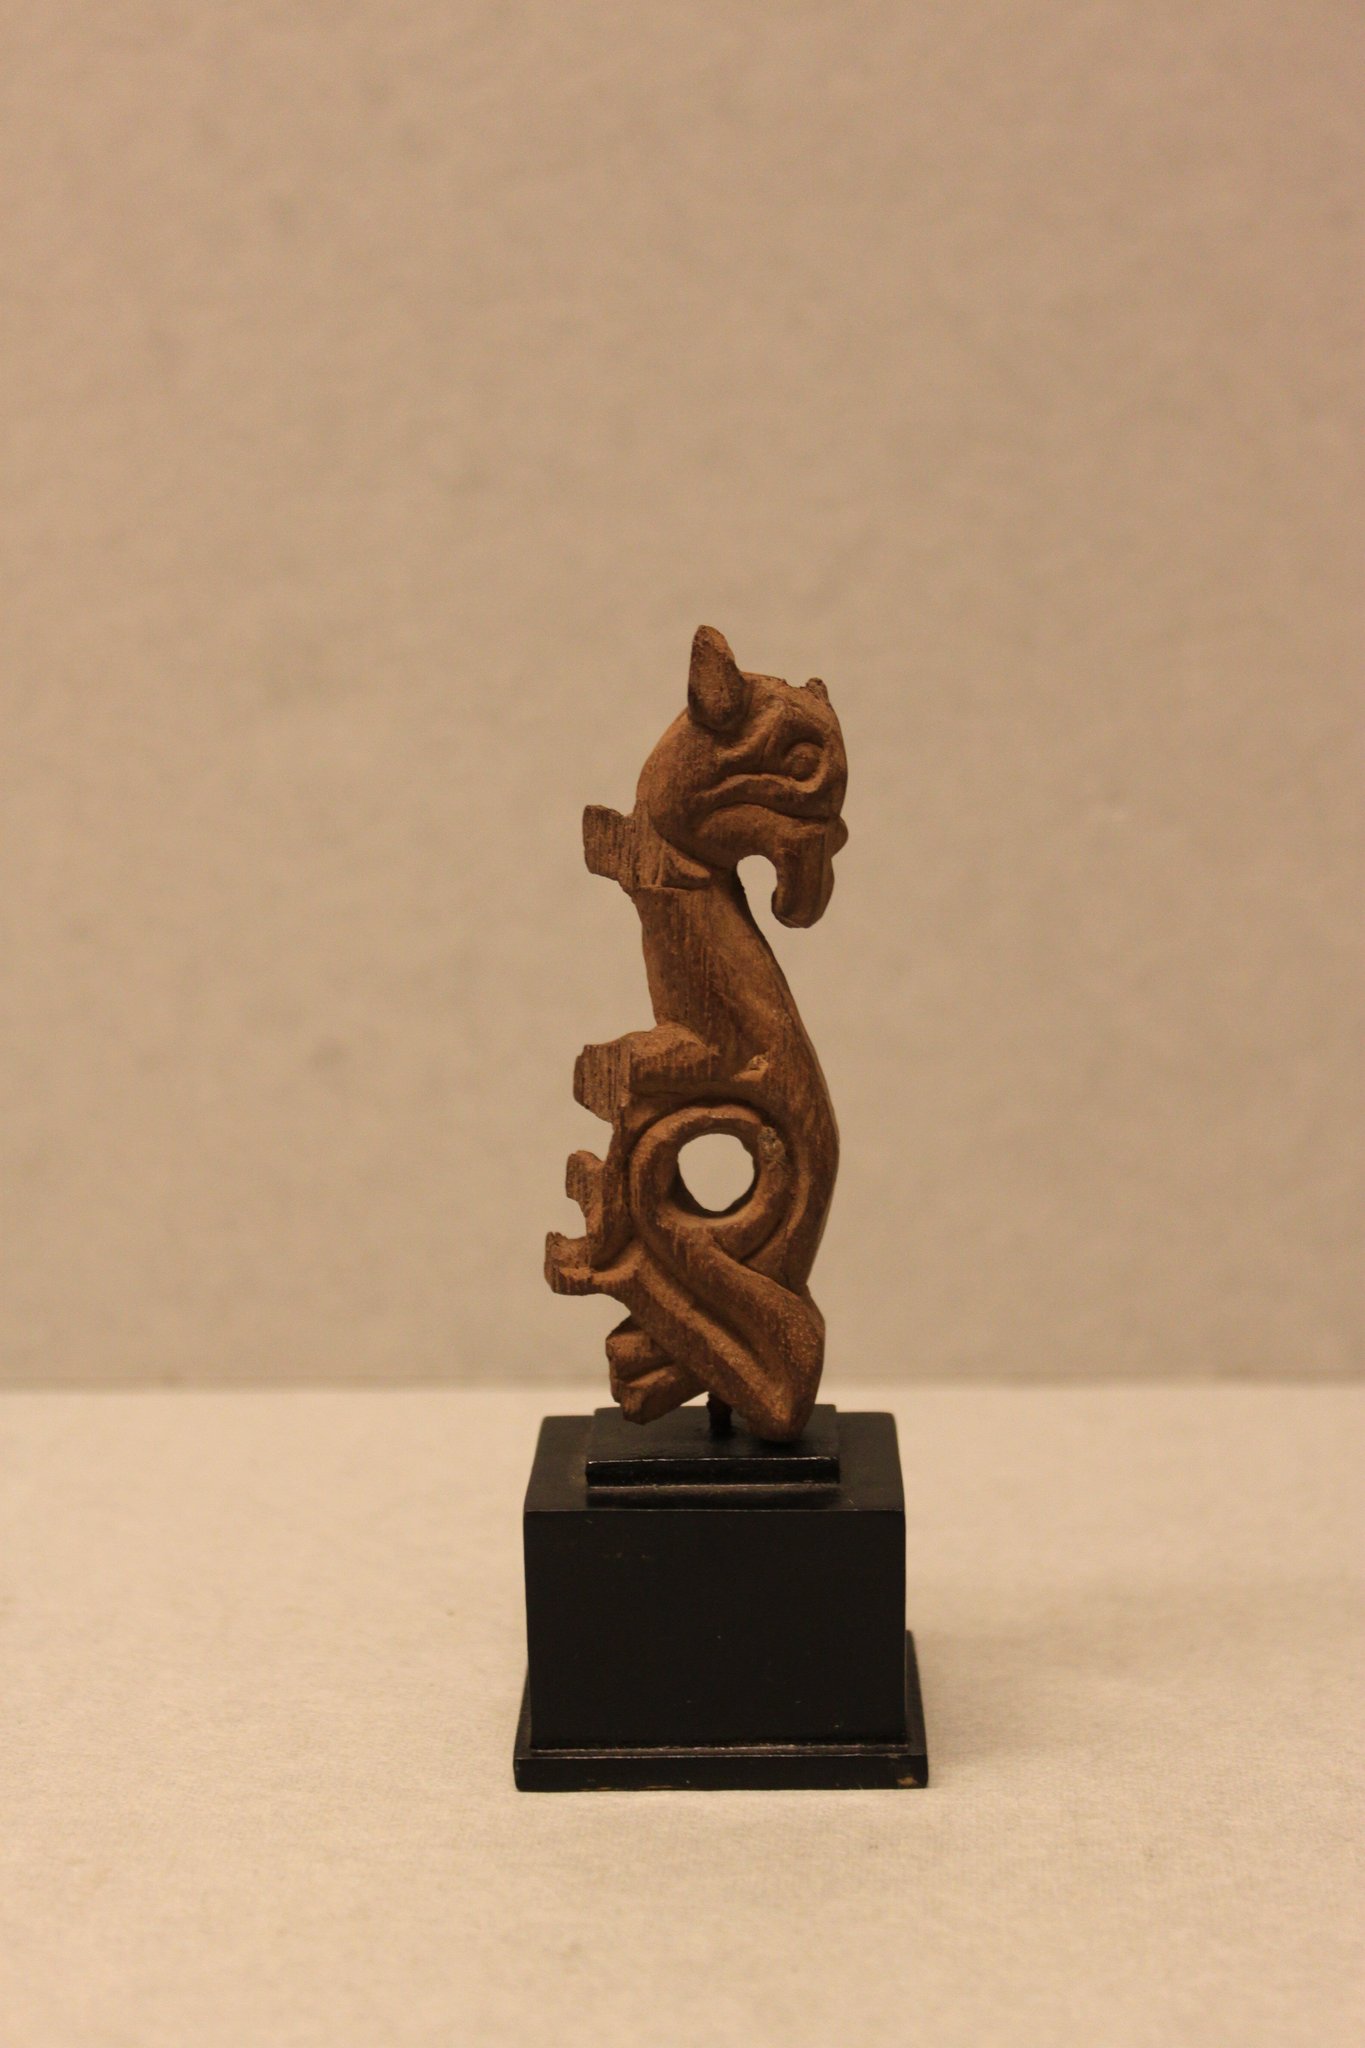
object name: panel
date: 901-1400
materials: wood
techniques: carving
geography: egypt